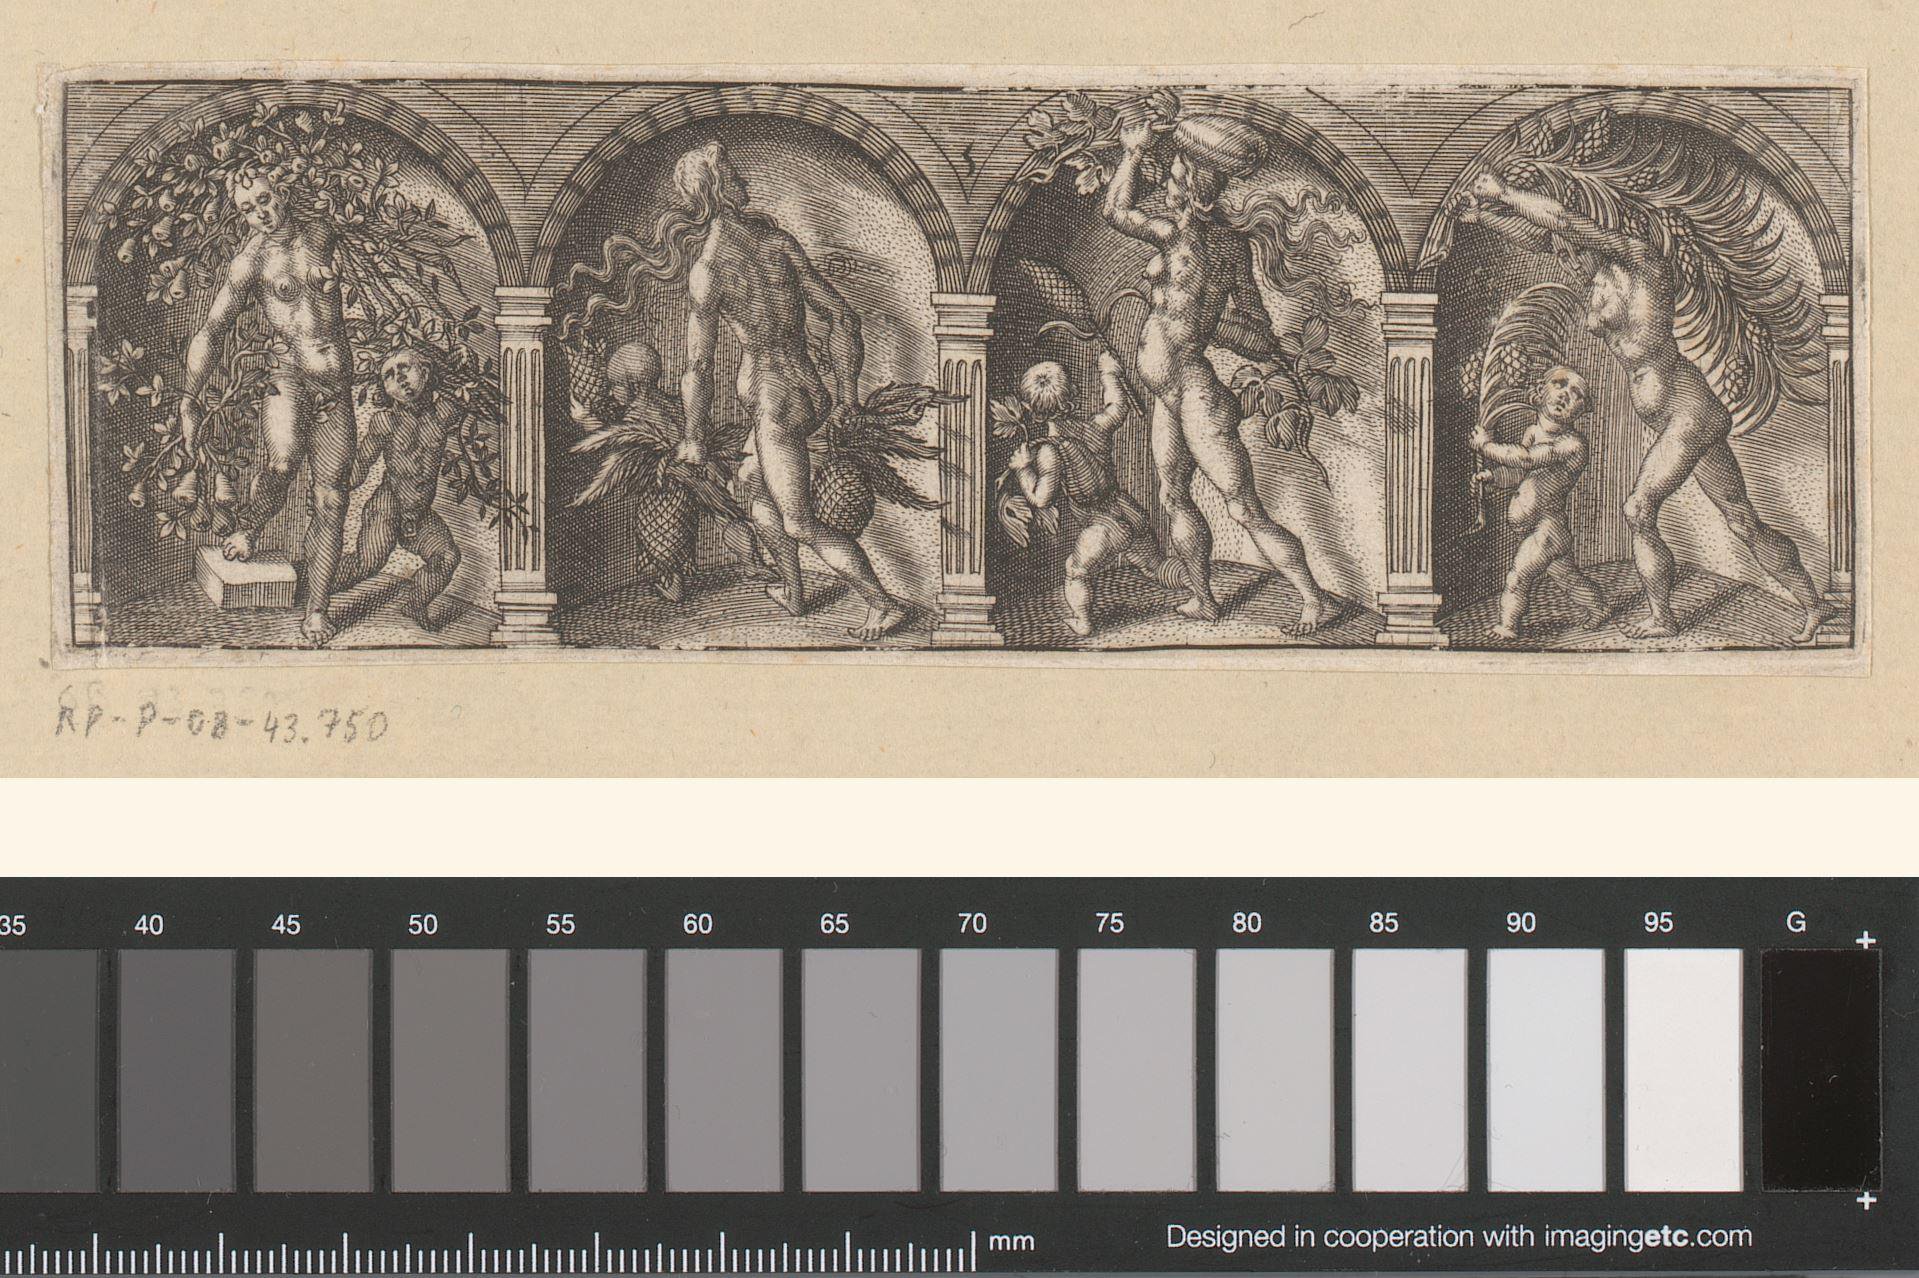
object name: print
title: Les Divers Pourtraicts & figures faictes sus les meurs Des habitans du Nouveau Monde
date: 1610-1640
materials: paper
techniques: engraving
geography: france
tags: parts of church interior: niche, woman (showing herself) undressed, quasi-nude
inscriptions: collector's mark: Lugt 240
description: In deze serie worden naakte figuren in vier architecturale niches geplaatst. Zij stellen de inwoners voor van de Nieuwe Wereld.